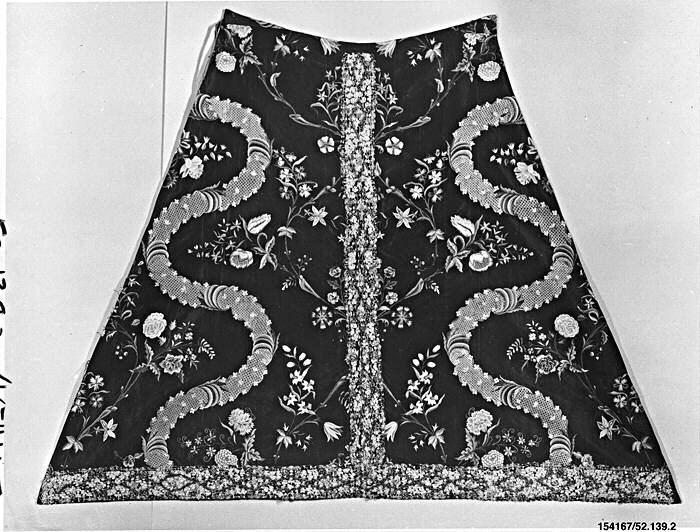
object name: skirt panel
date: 1701-1800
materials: silk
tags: flowers